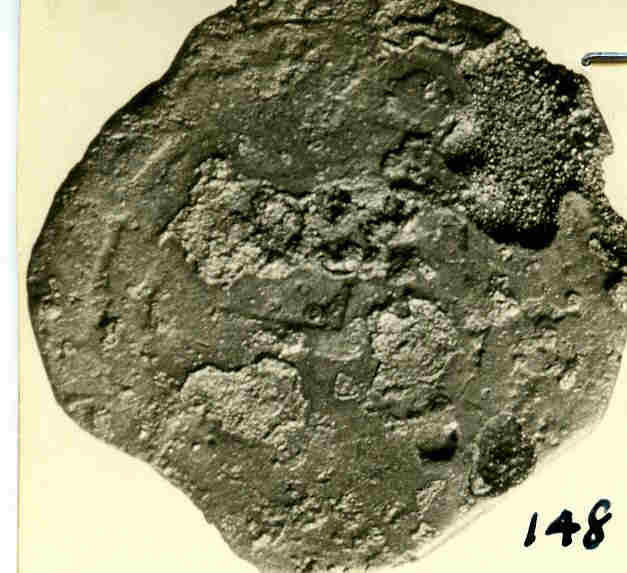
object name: coin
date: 758-768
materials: copper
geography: iran